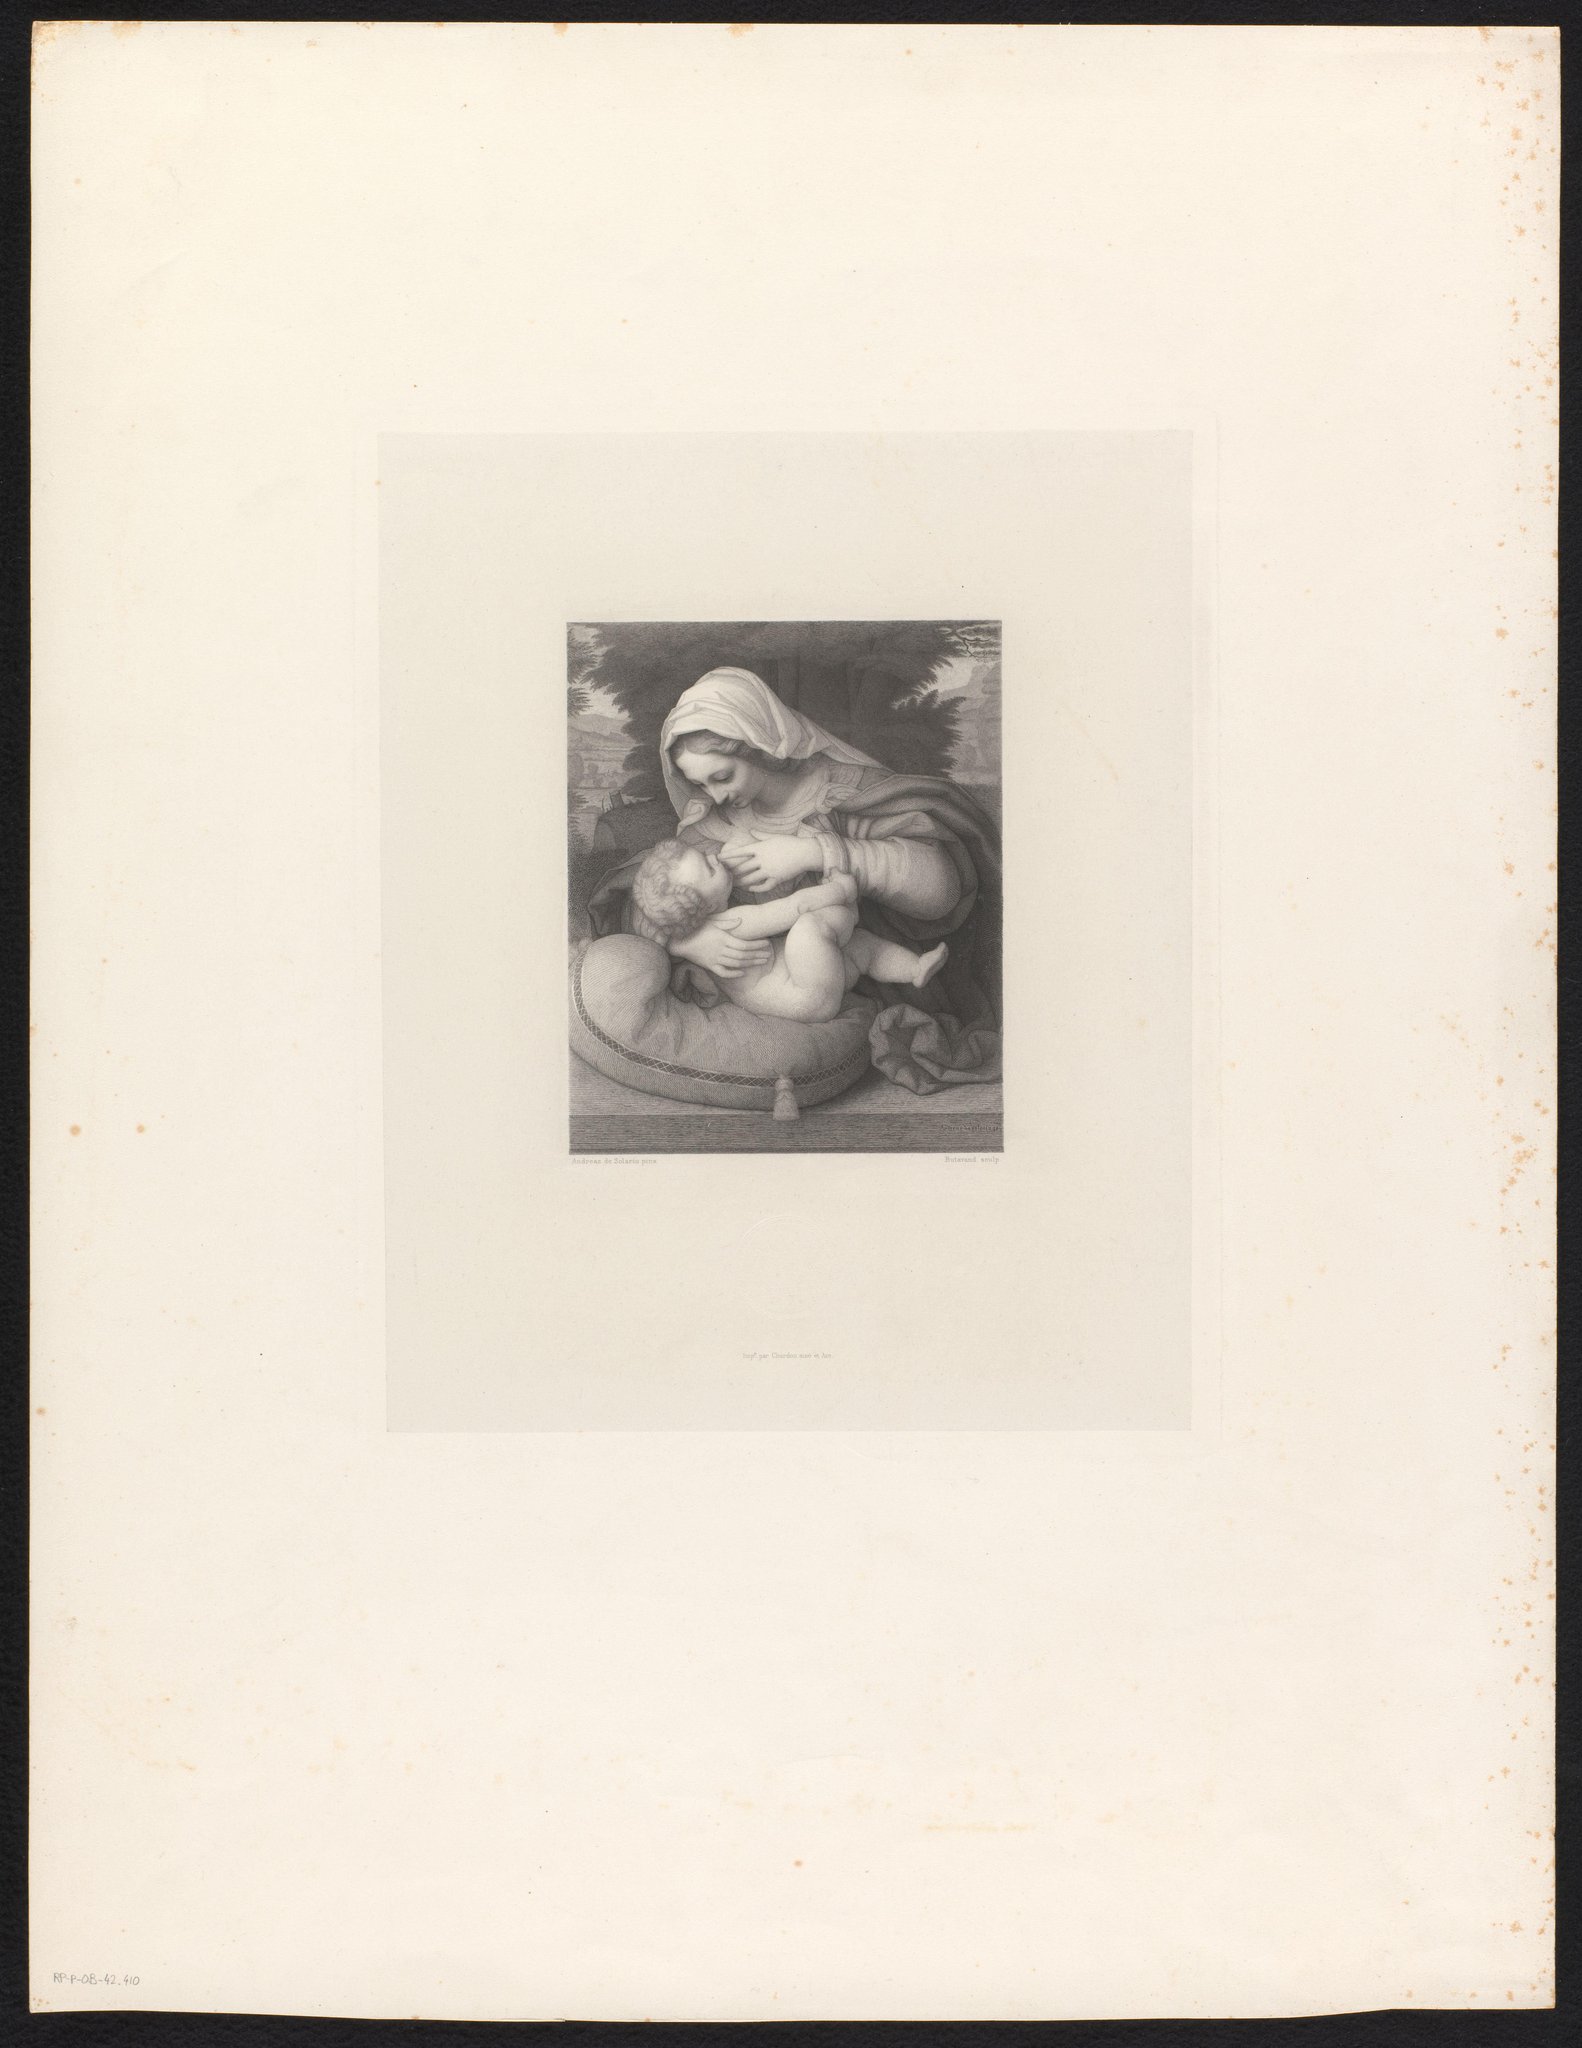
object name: print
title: Maria met het Christuskind aan de borst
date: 1851-1852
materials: paper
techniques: engraving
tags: christ-child suckling, or beginning to suckle, e.g. mary uncovering her breast ~ madonna-representations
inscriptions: collector's mark: Lugt 12, check stamp: ‘Societe des Amis des Arts De Lyon’